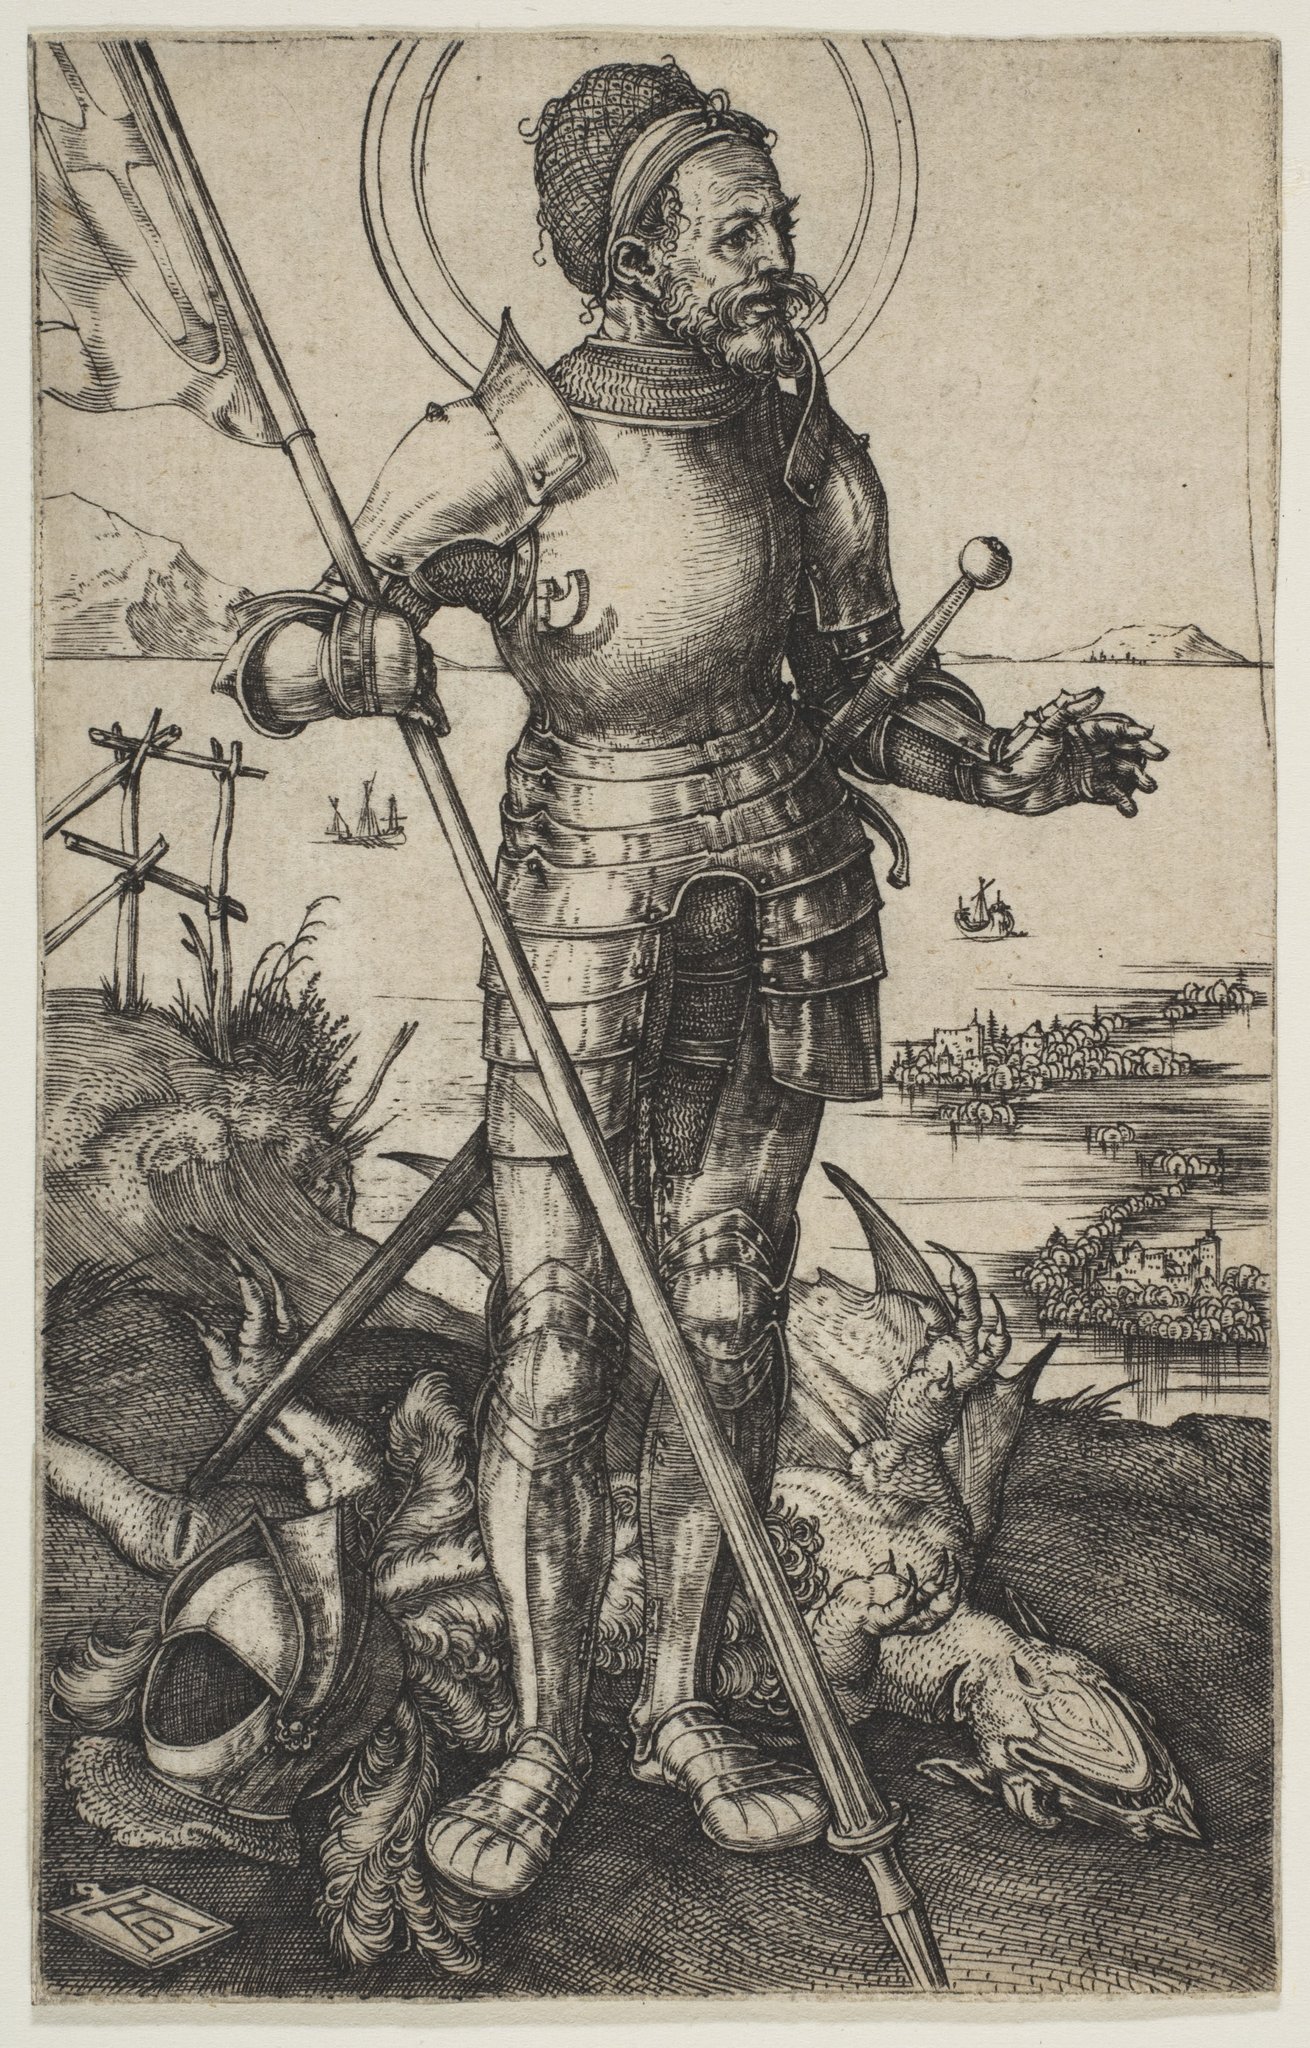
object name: print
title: Saint George Standing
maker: albrecht dürer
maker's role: artist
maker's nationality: german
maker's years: 1471-1528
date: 1502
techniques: engraving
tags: armor,swords,saint george,flags